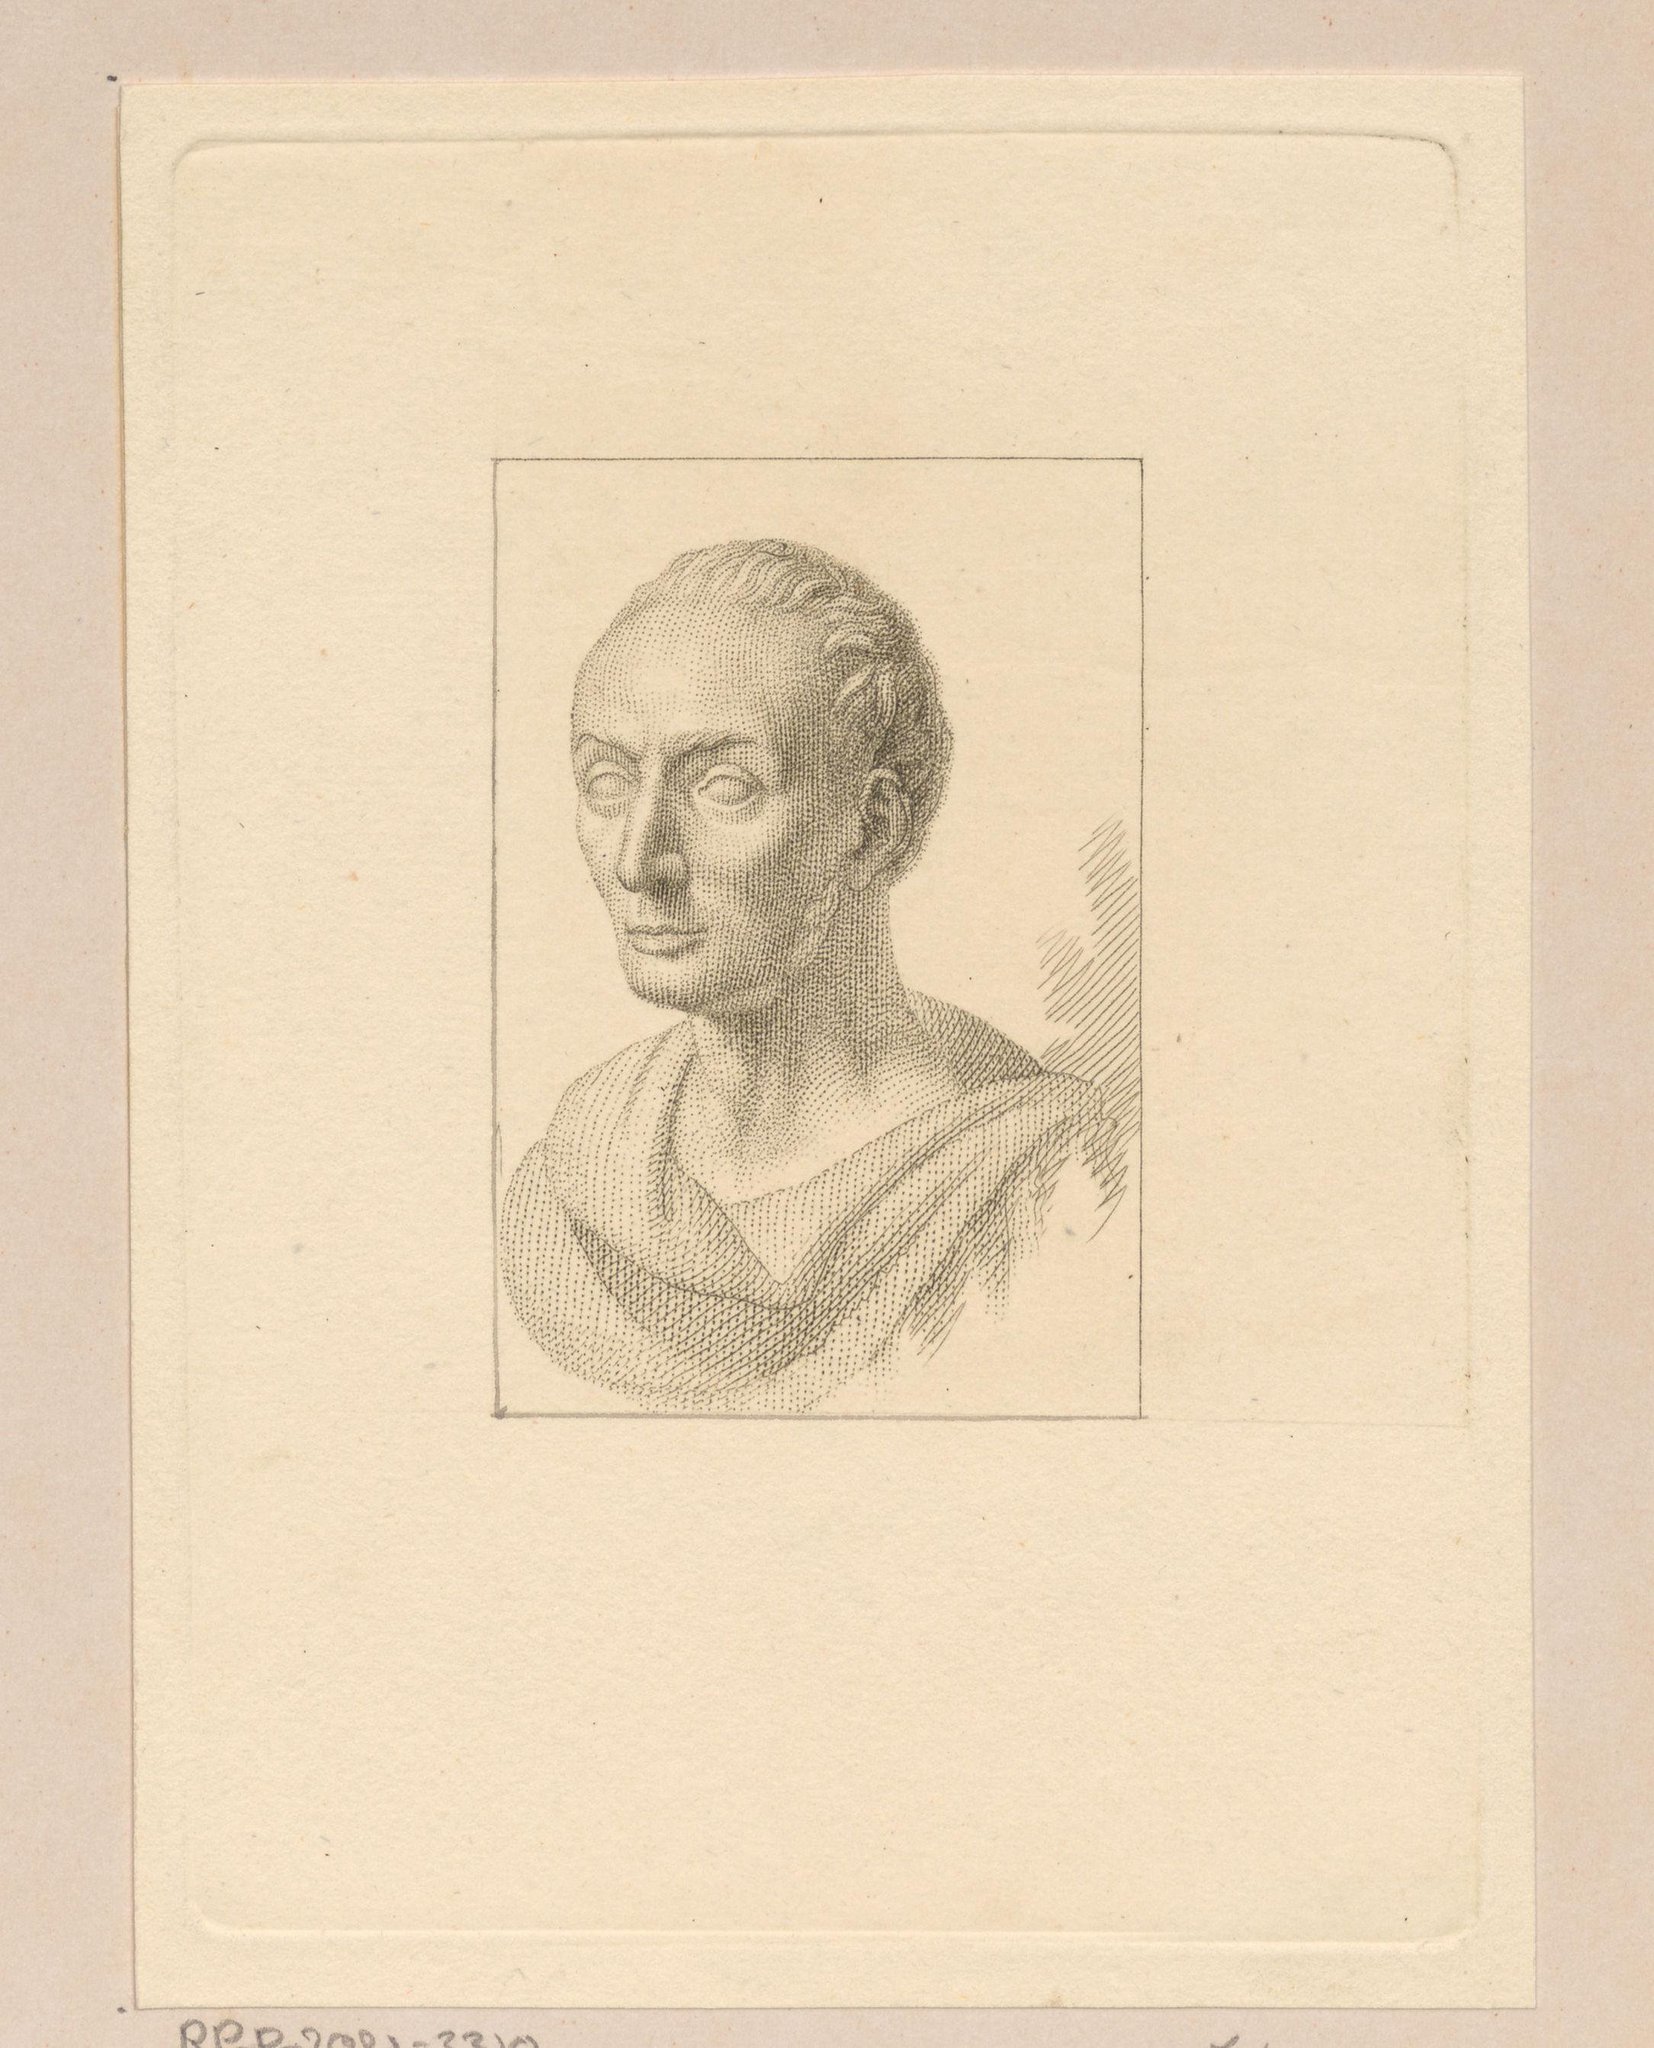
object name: print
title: Portret van Jacques Kuyper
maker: jacob ernst marcus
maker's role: draughtsman, print maker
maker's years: 1774-1826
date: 1784-1826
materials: paper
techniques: engraving, etching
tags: amsterdam, print maker, draughtsman, jacques kuyper, historical persons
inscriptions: collector's mark: Lugt 924